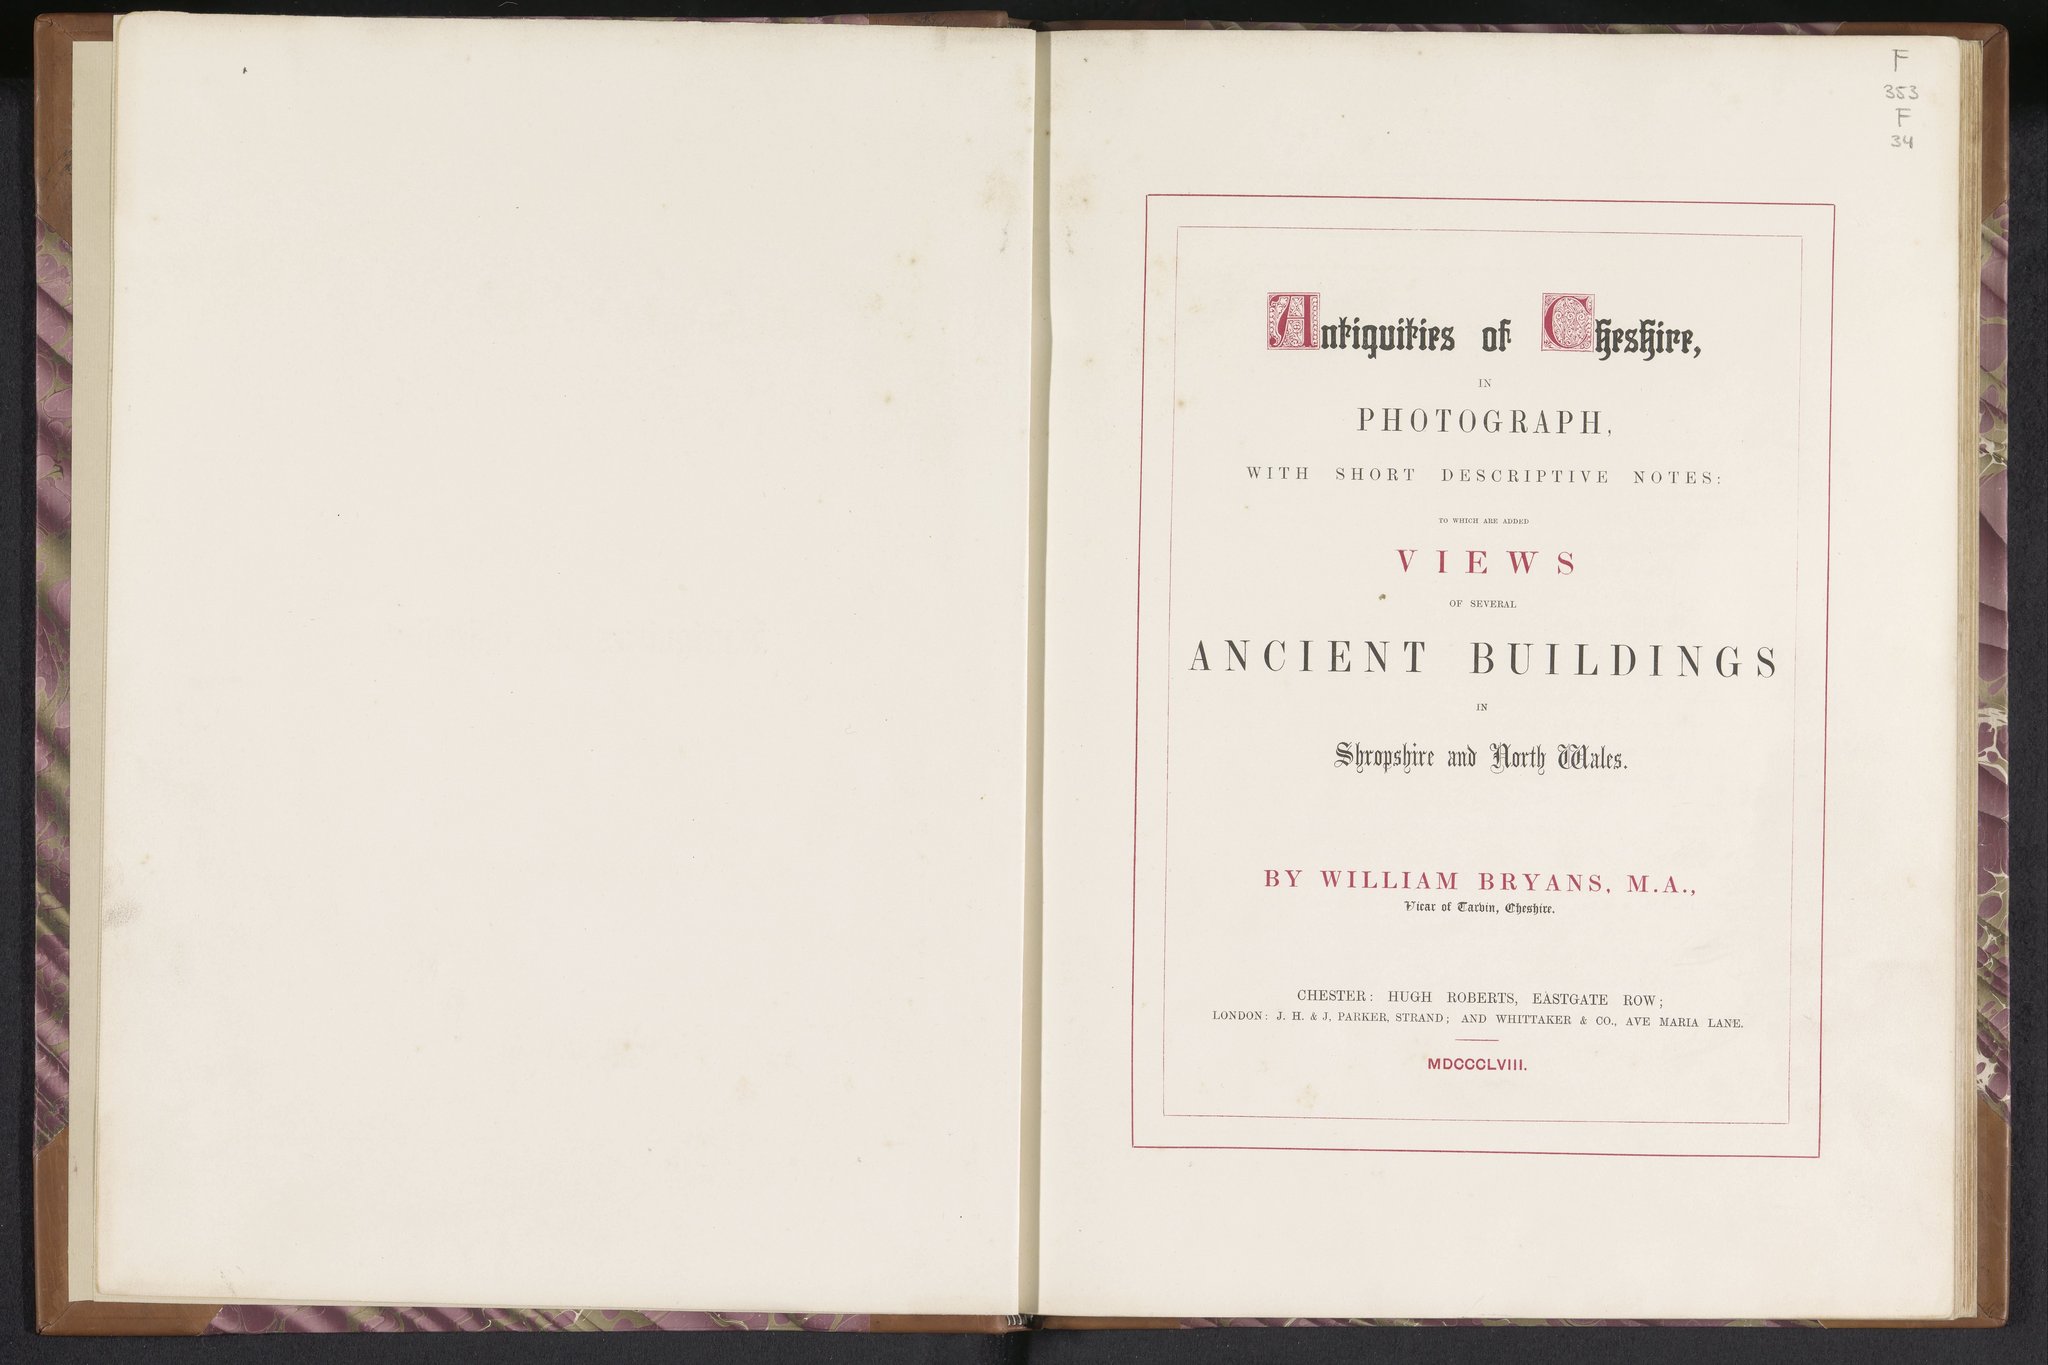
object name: book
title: Antiquities of Cheshire in photograph, with short descriptive notes to which are added views of several ancient building in Shropshire and North Wales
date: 1858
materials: leather, paper, photographic support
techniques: albumen print, marbling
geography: london